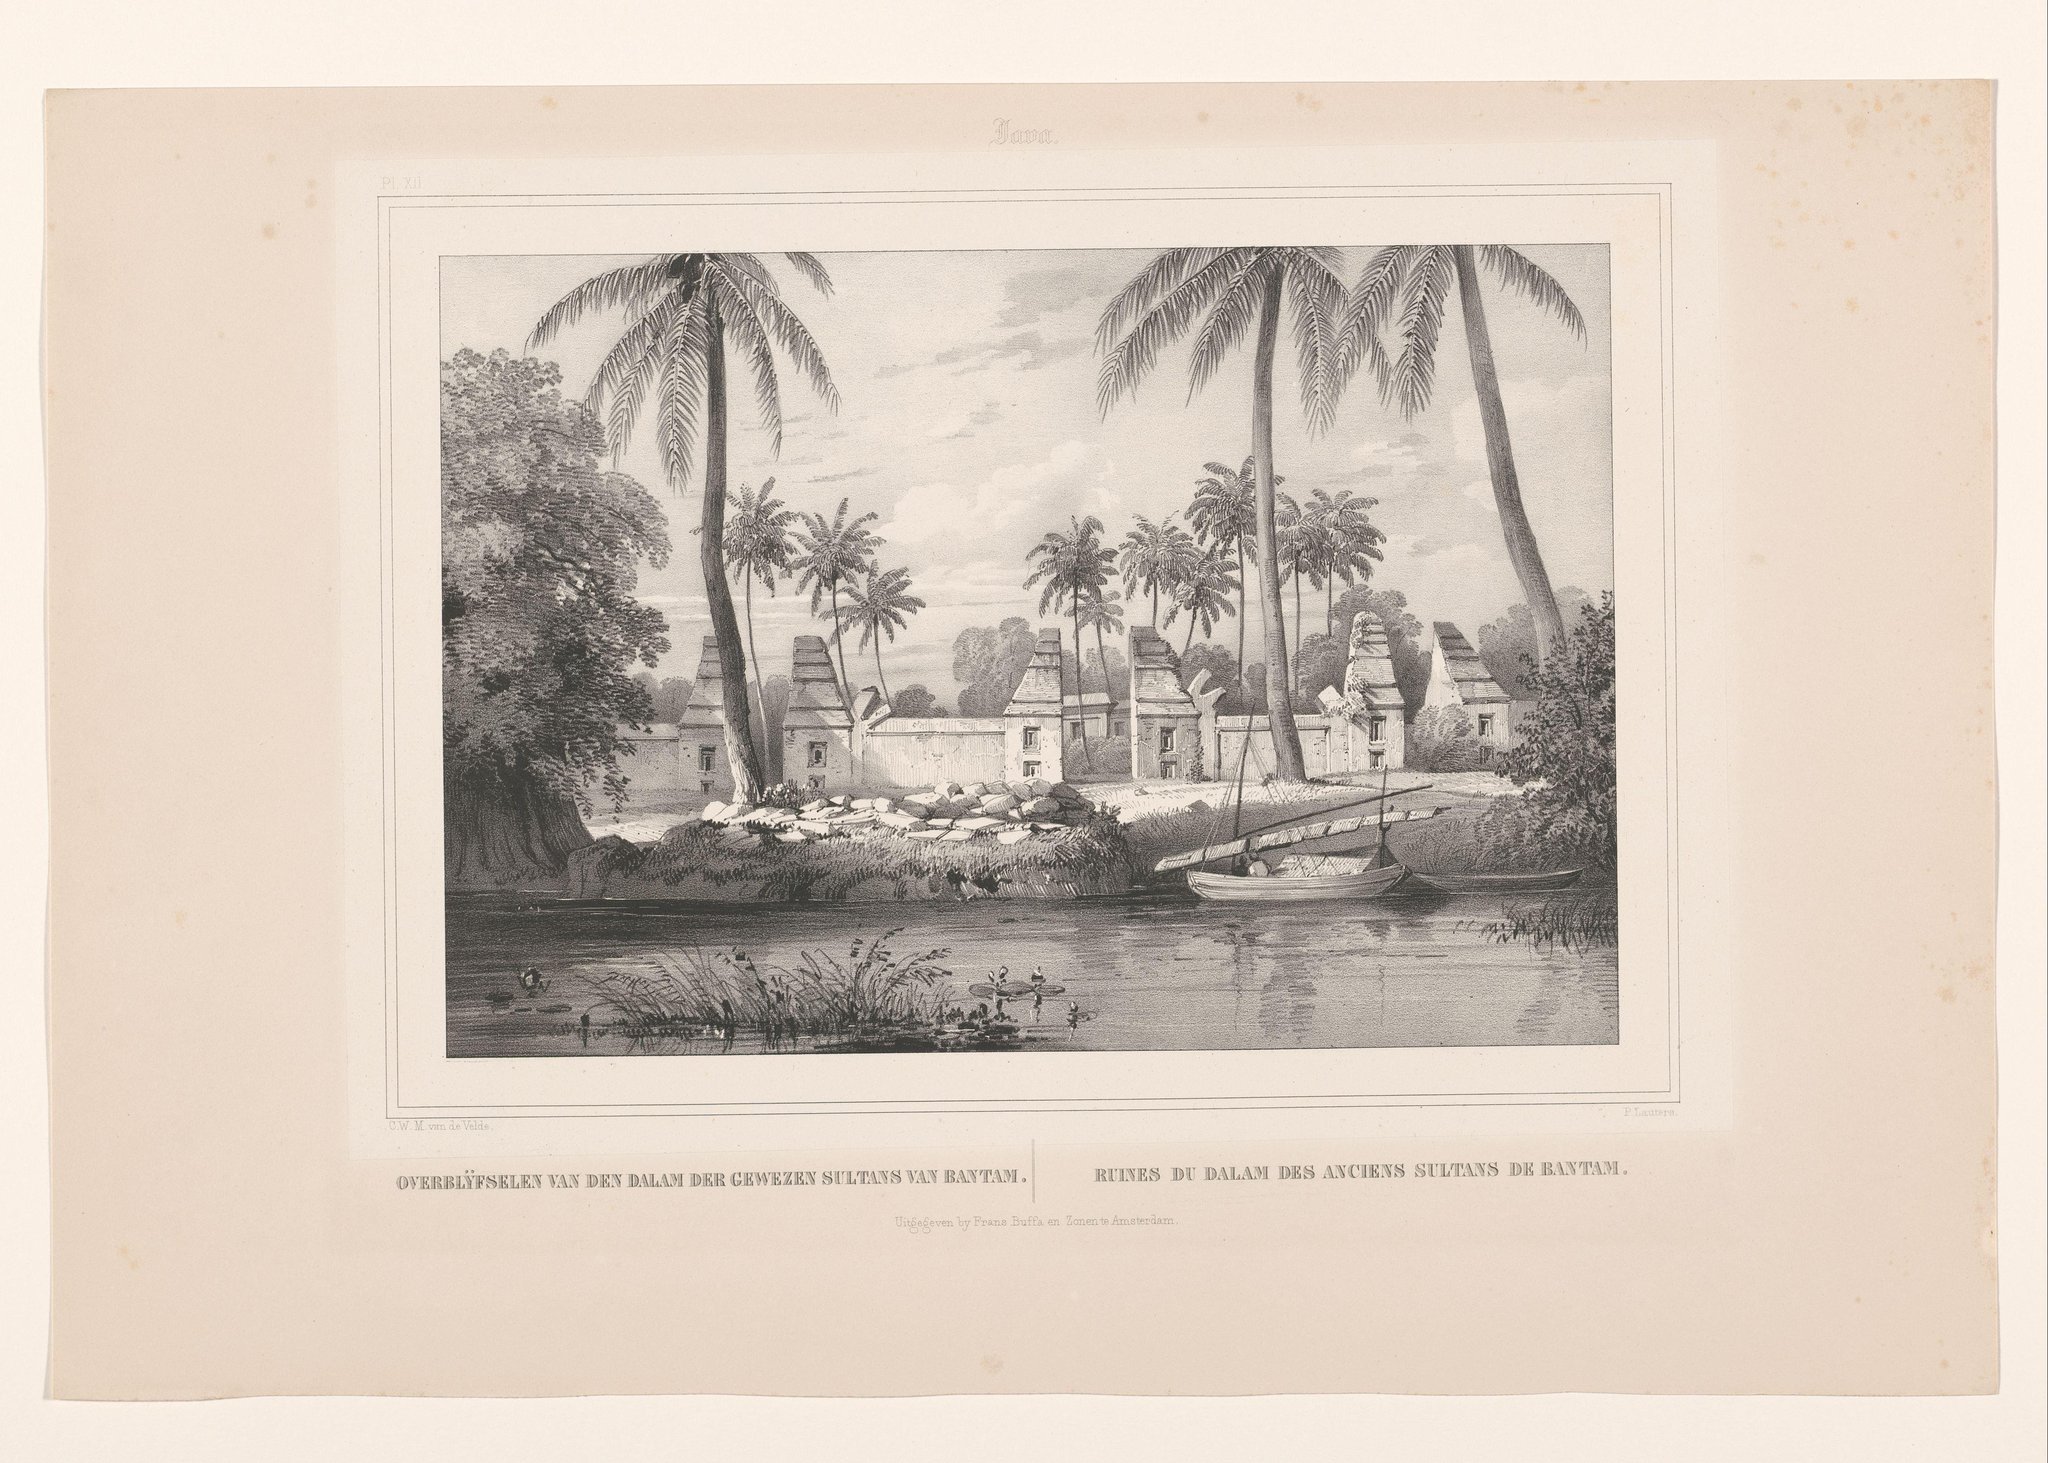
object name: print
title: Overblijfselen van den Dalam der gewezen sultans van Bantam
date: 1843-1845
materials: paper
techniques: lithograph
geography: amsterdam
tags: ruin of a building ~ architecture, palace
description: Op het water ligt een boot met twee figuren. Genummerd linksboven: Pl. XII. De prent maakt deel uit van een omslag met zes bladen.